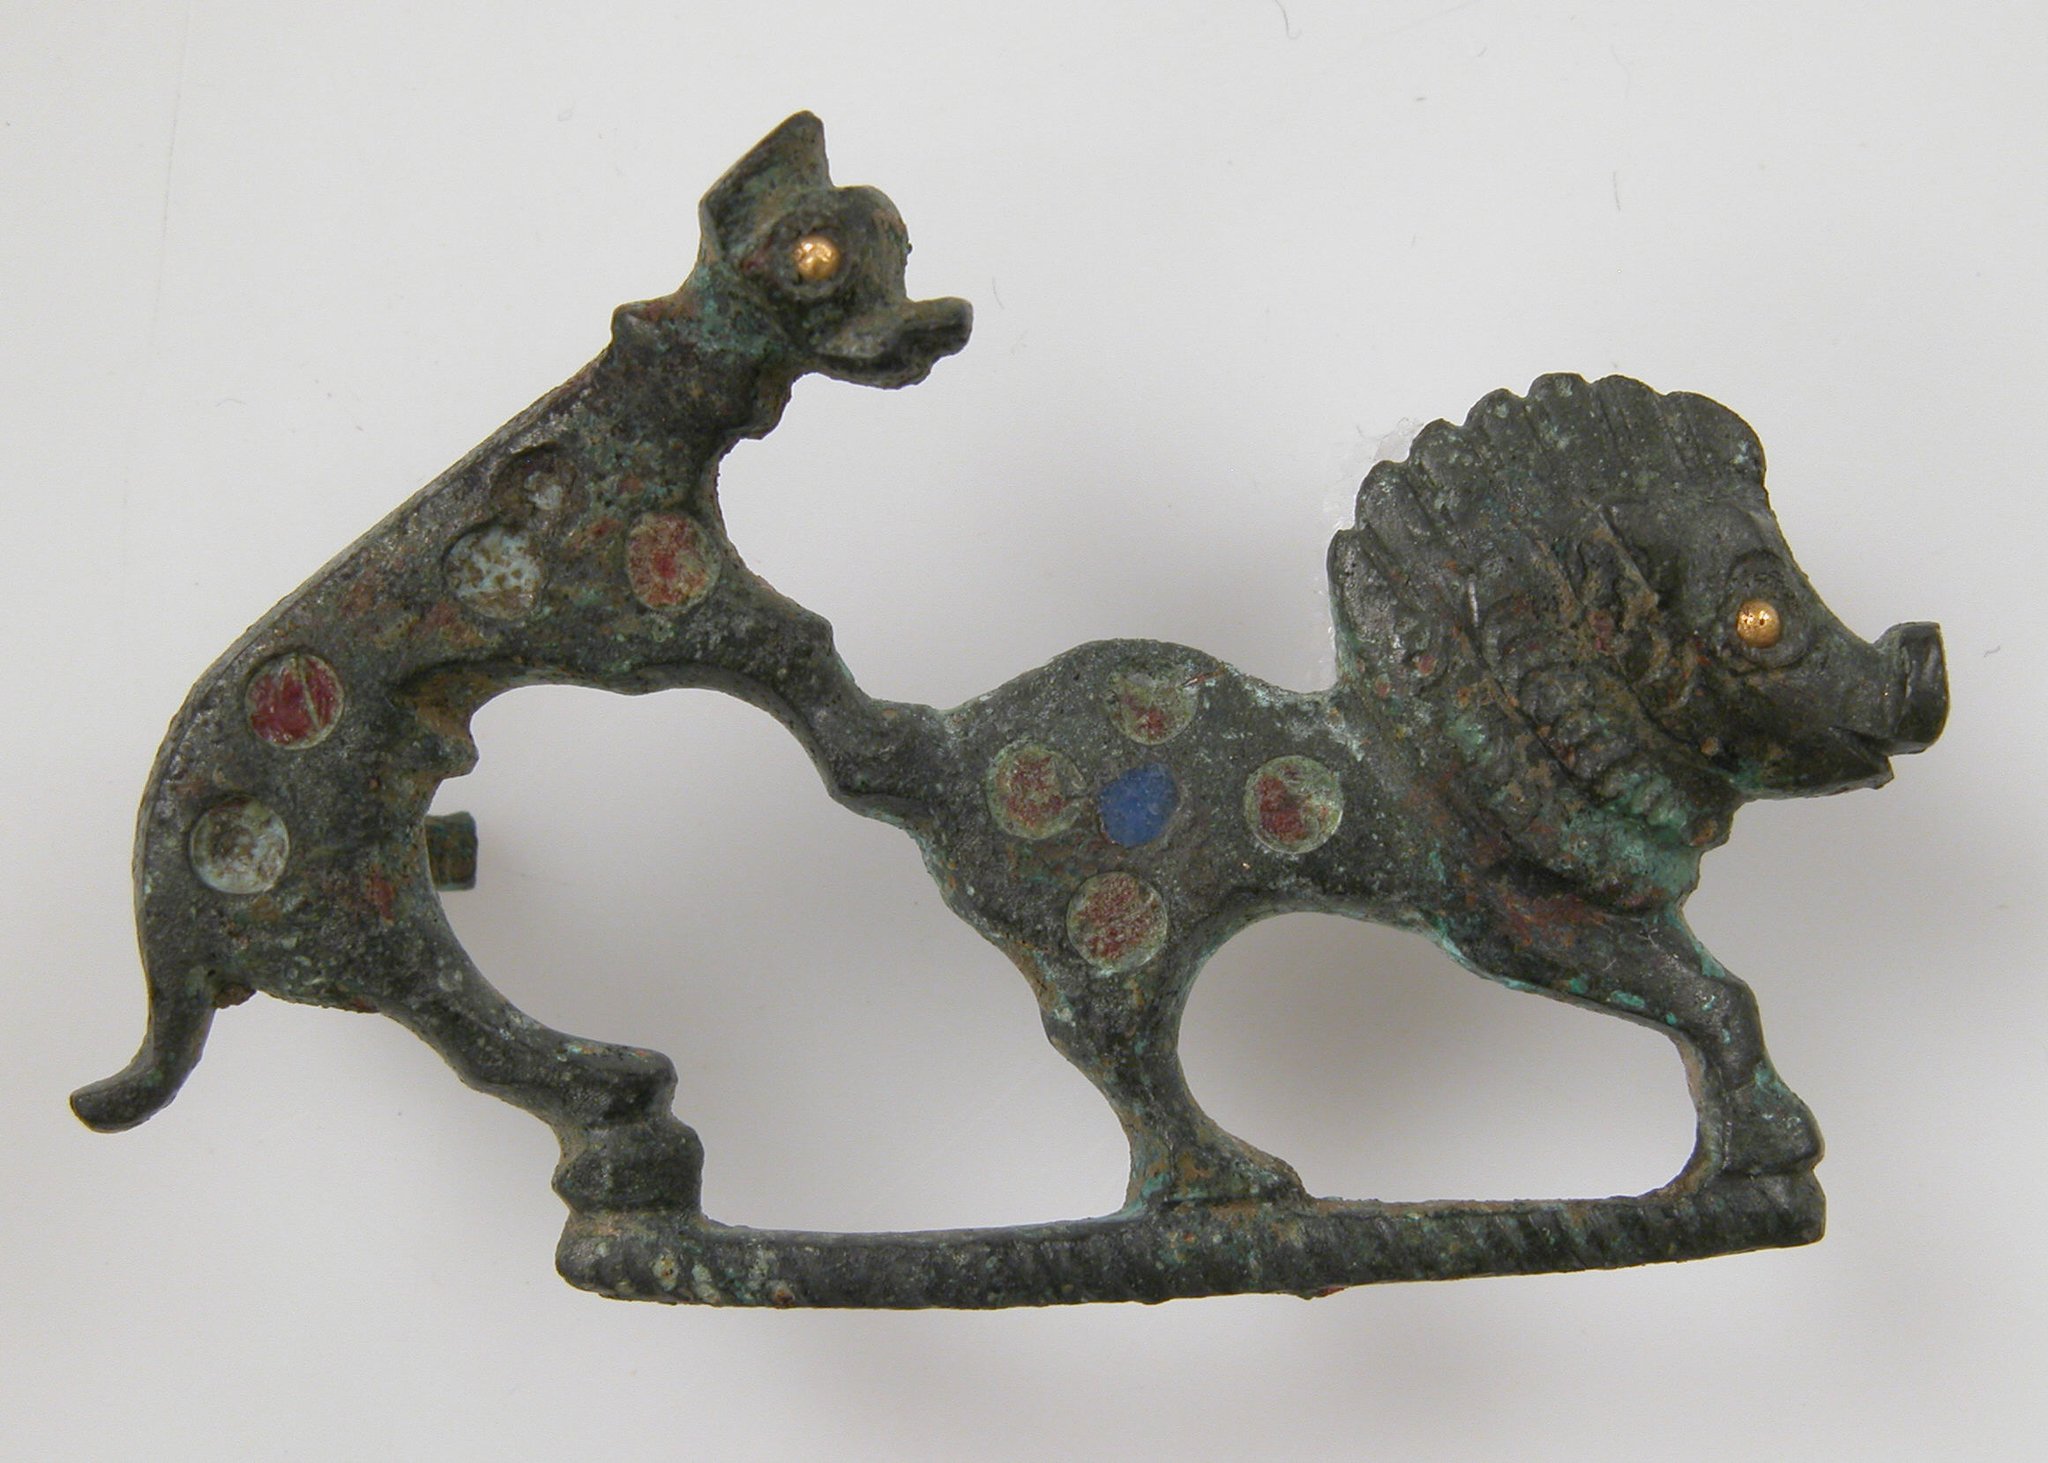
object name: brooch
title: Animal-Shaped Brooch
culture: roman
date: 101-200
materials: bronze, enamel, gold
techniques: enamel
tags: animals